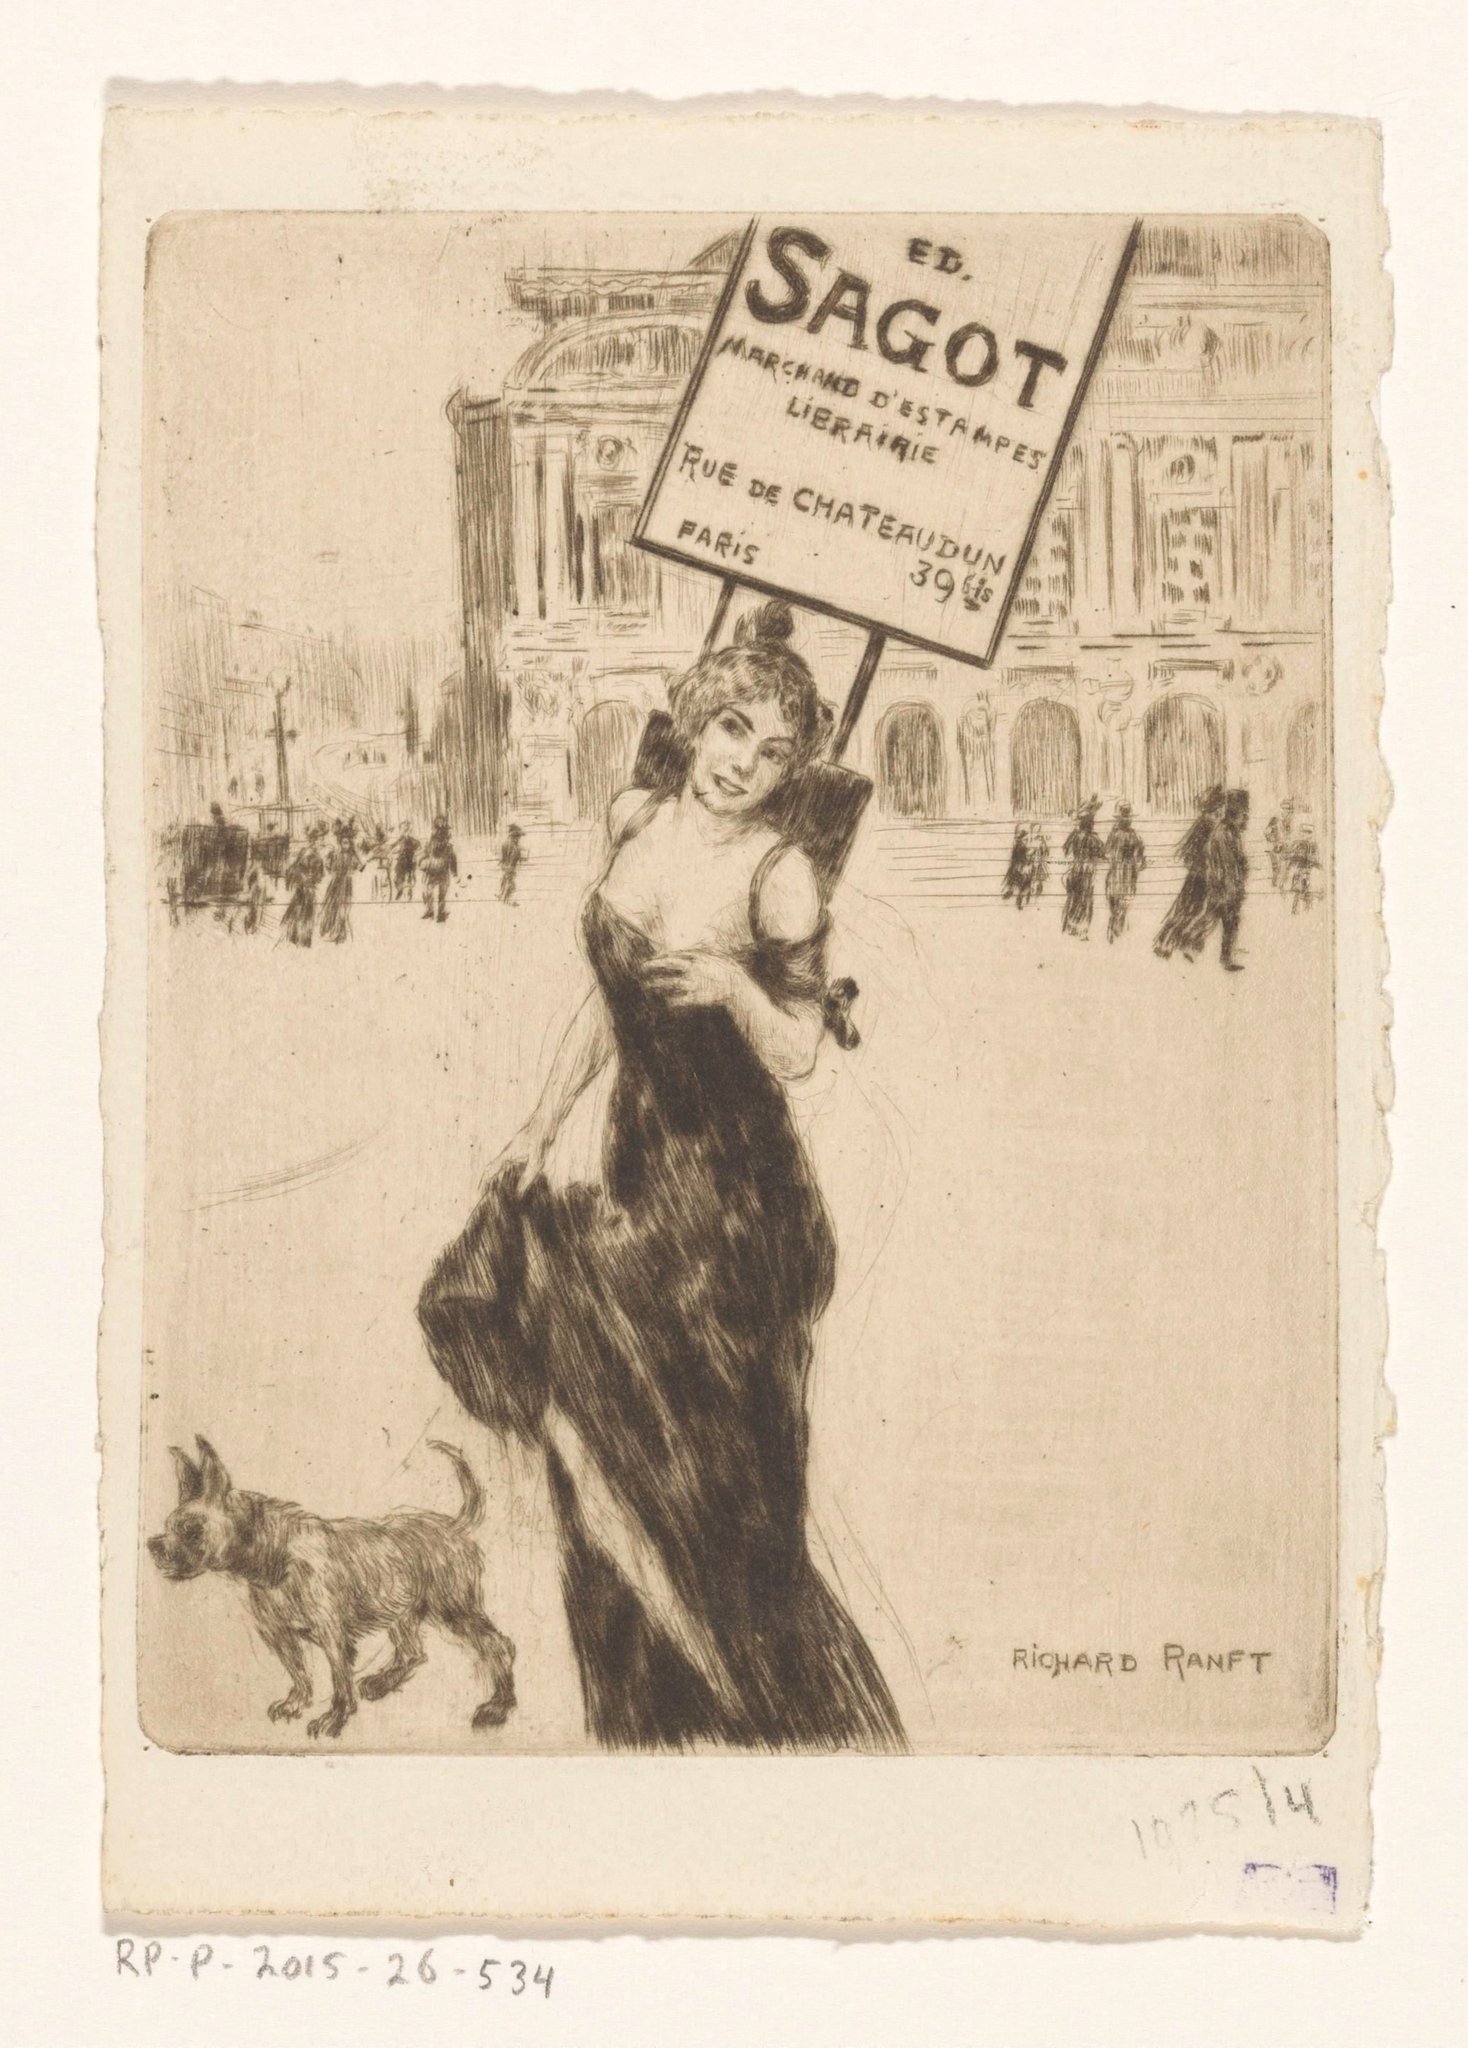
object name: visiting card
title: Visitekaartje van prenthandelaar Edmond Sagot te Parijs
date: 1881-1917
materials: paper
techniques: drypoint, intaglio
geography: paris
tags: bill-board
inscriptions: collector's mark: Lugt 2228, collector's mark: Lugt 4780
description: Een jonge vrouw met een reclamebord op haar rug op een plein, mogelijk de Place de l'Opera.